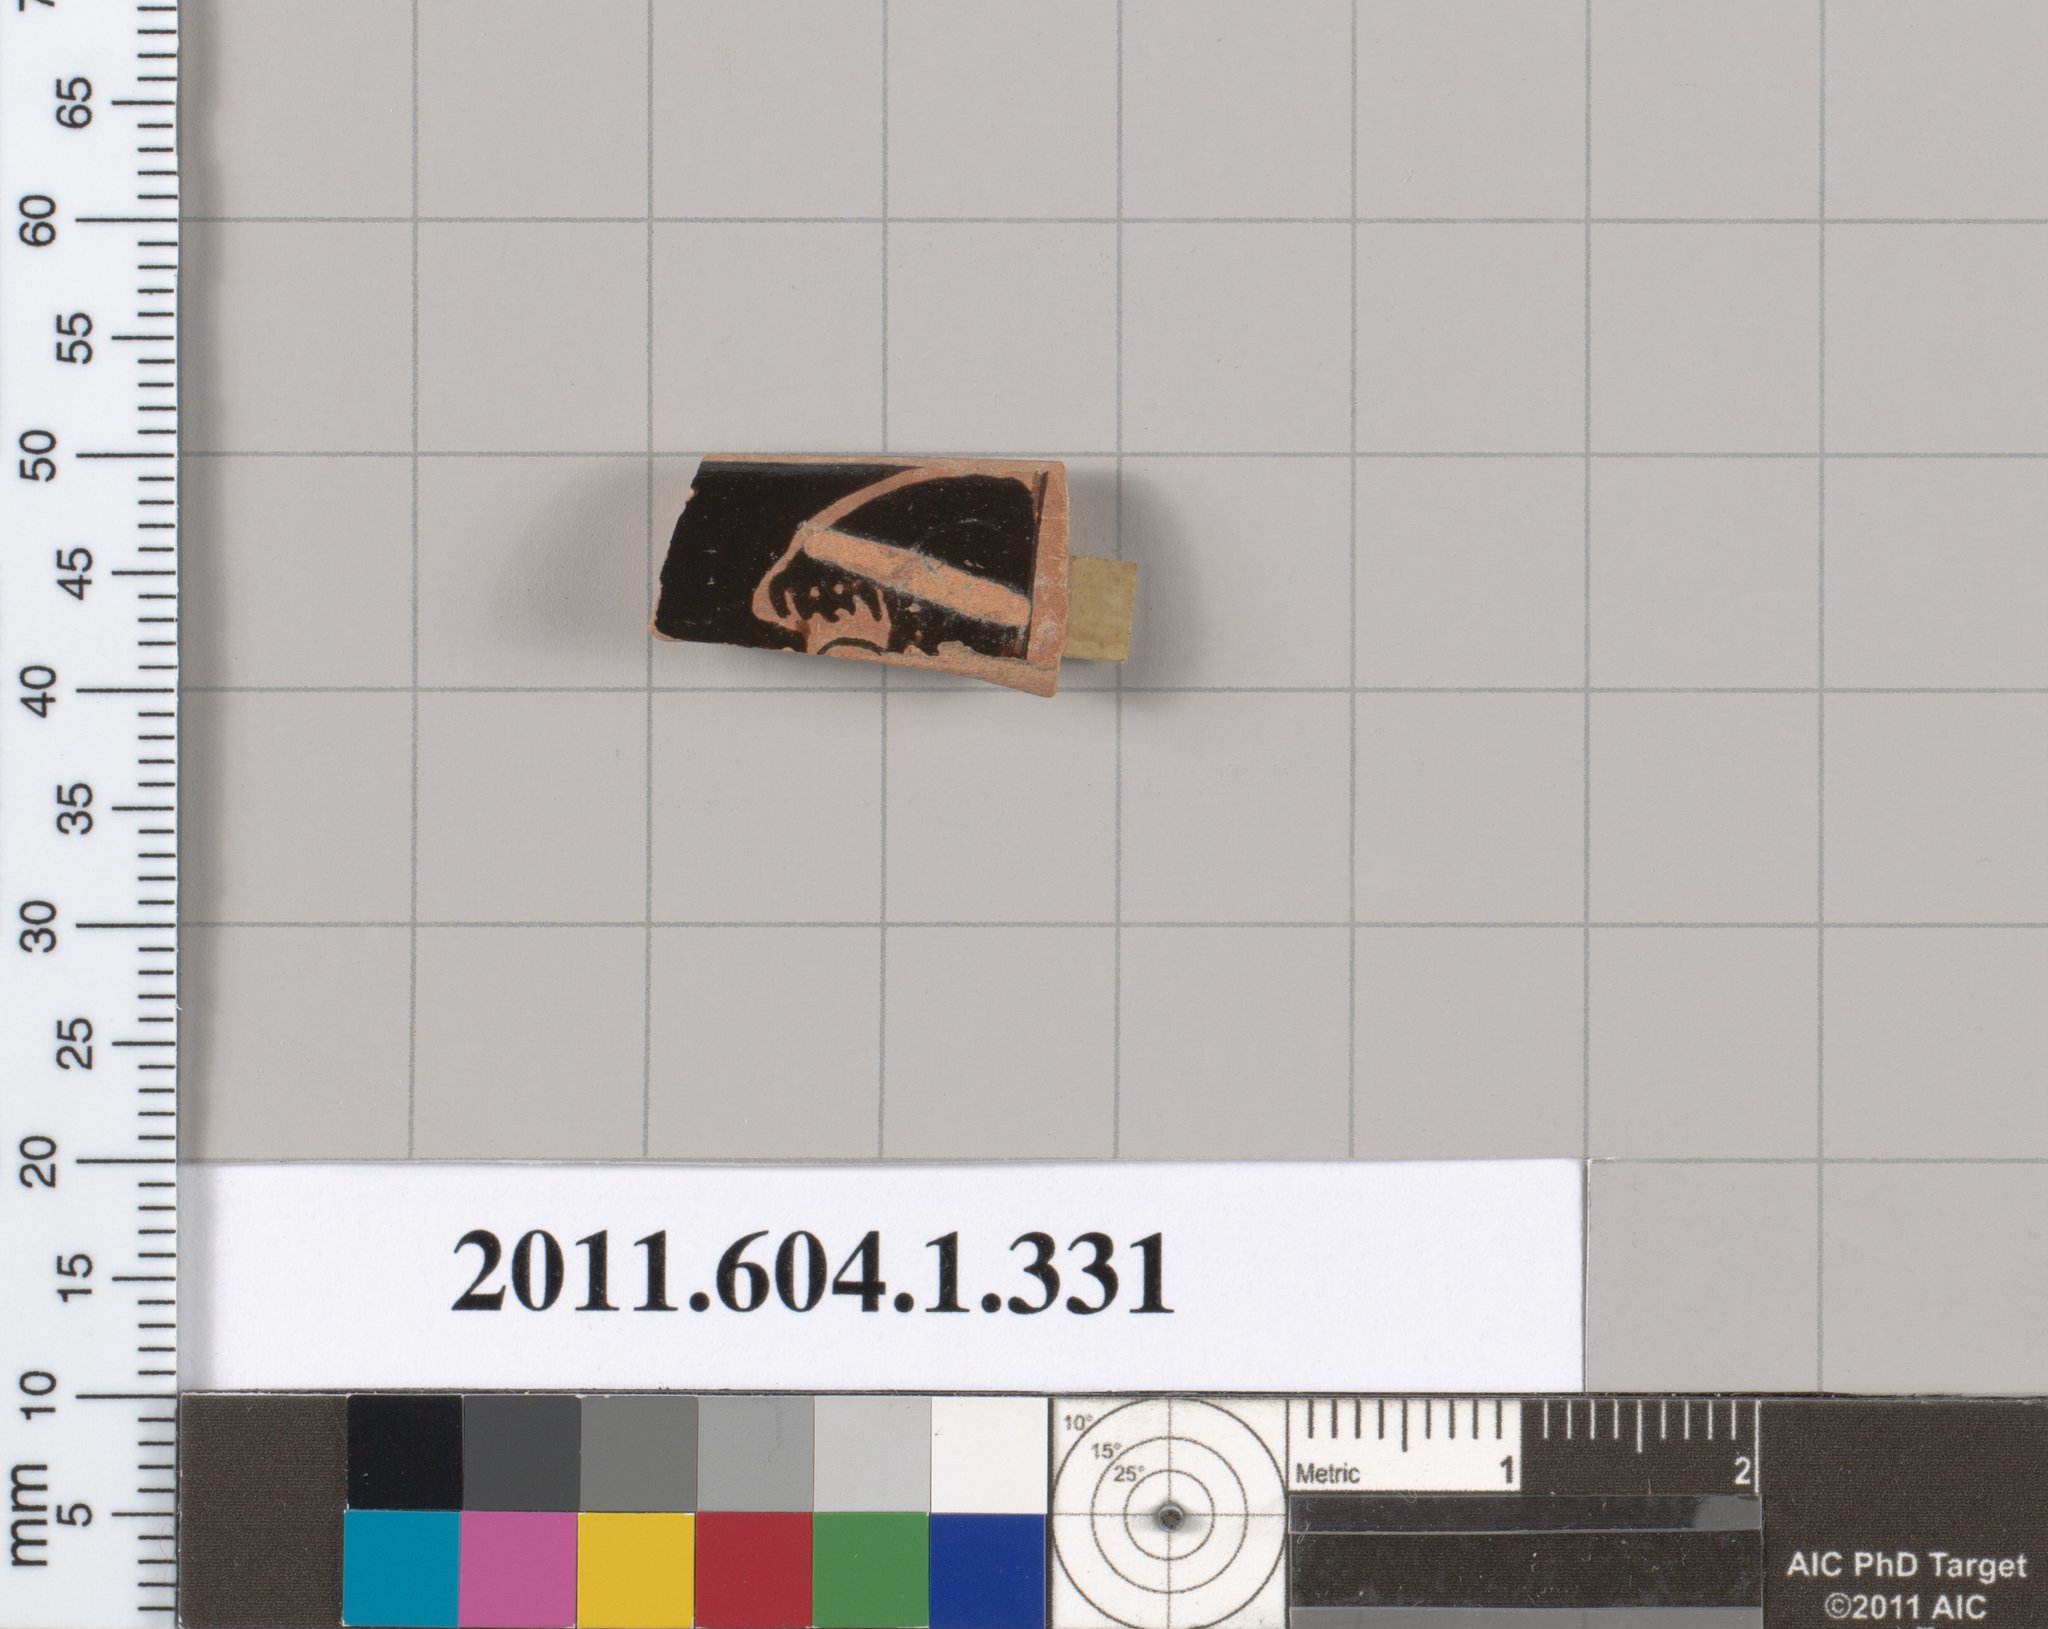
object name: kylix fragment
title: Terracotta rim fragment of a kylix (drinking cup)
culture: greek, attic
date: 475-451 BCE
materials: terracotta